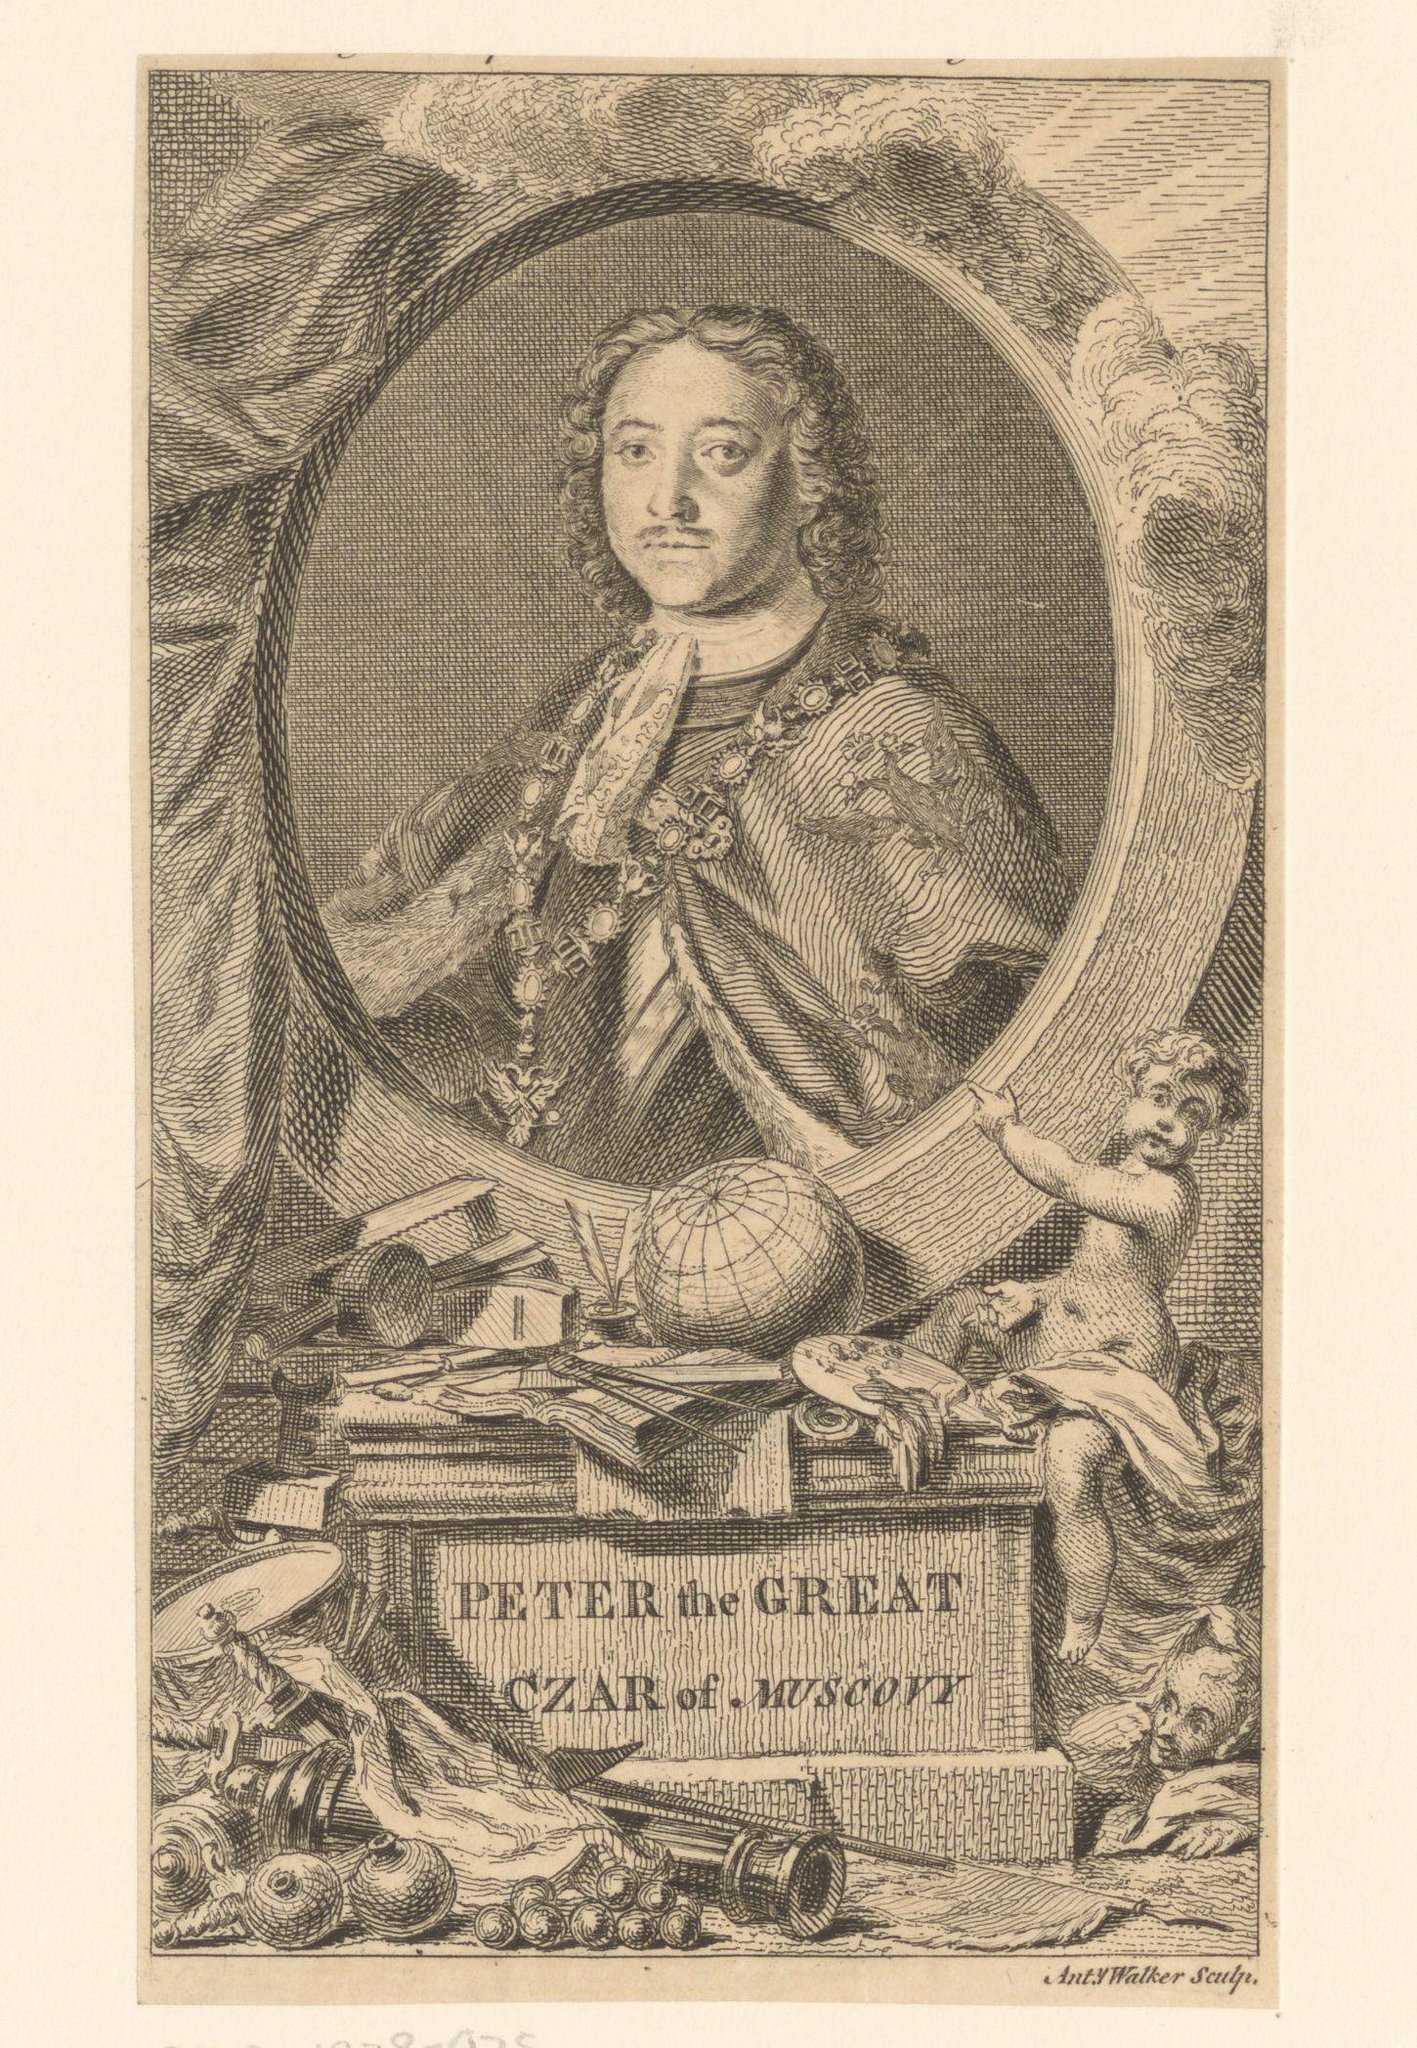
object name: print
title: Portret van Peter I de Grote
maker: anthony walker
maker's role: print maker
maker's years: 1726-1765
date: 1736-1765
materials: paper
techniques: engraving, etching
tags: peter i de grote (tsaar van rusland), the liberal arts, 'artes liberales', historical persons, ruler, sovereign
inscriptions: collector's mark: Lugt 2228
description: Attributen van de vrije kunsten en oorlog onder de sokkel.